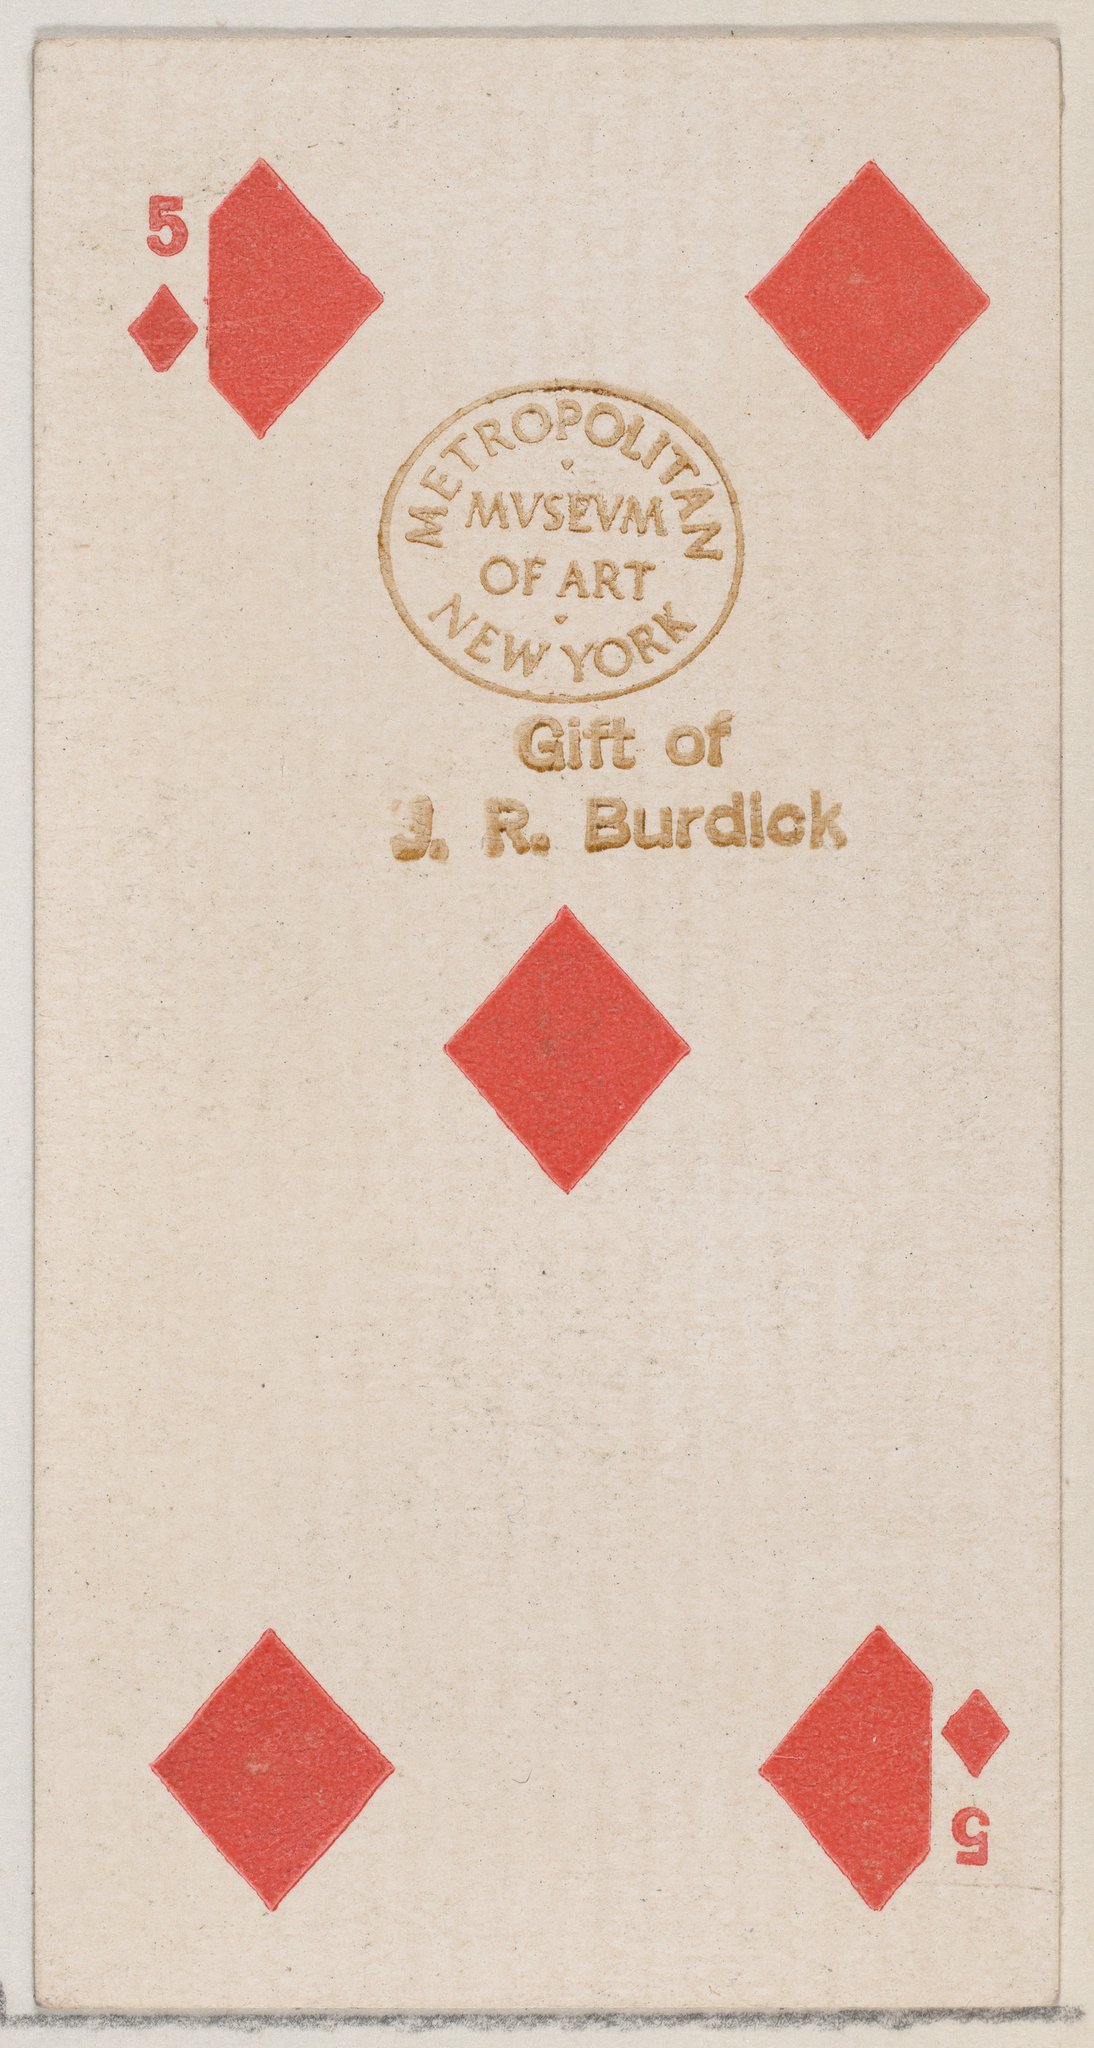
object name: print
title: Five Diamonds (red), from the Playing Cards series (N84) for Duke brand cigarettes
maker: w. duke, sons & co.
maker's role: publisher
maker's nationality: american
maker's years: 1870-1920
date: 1888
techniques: color lithograph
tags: playing cards